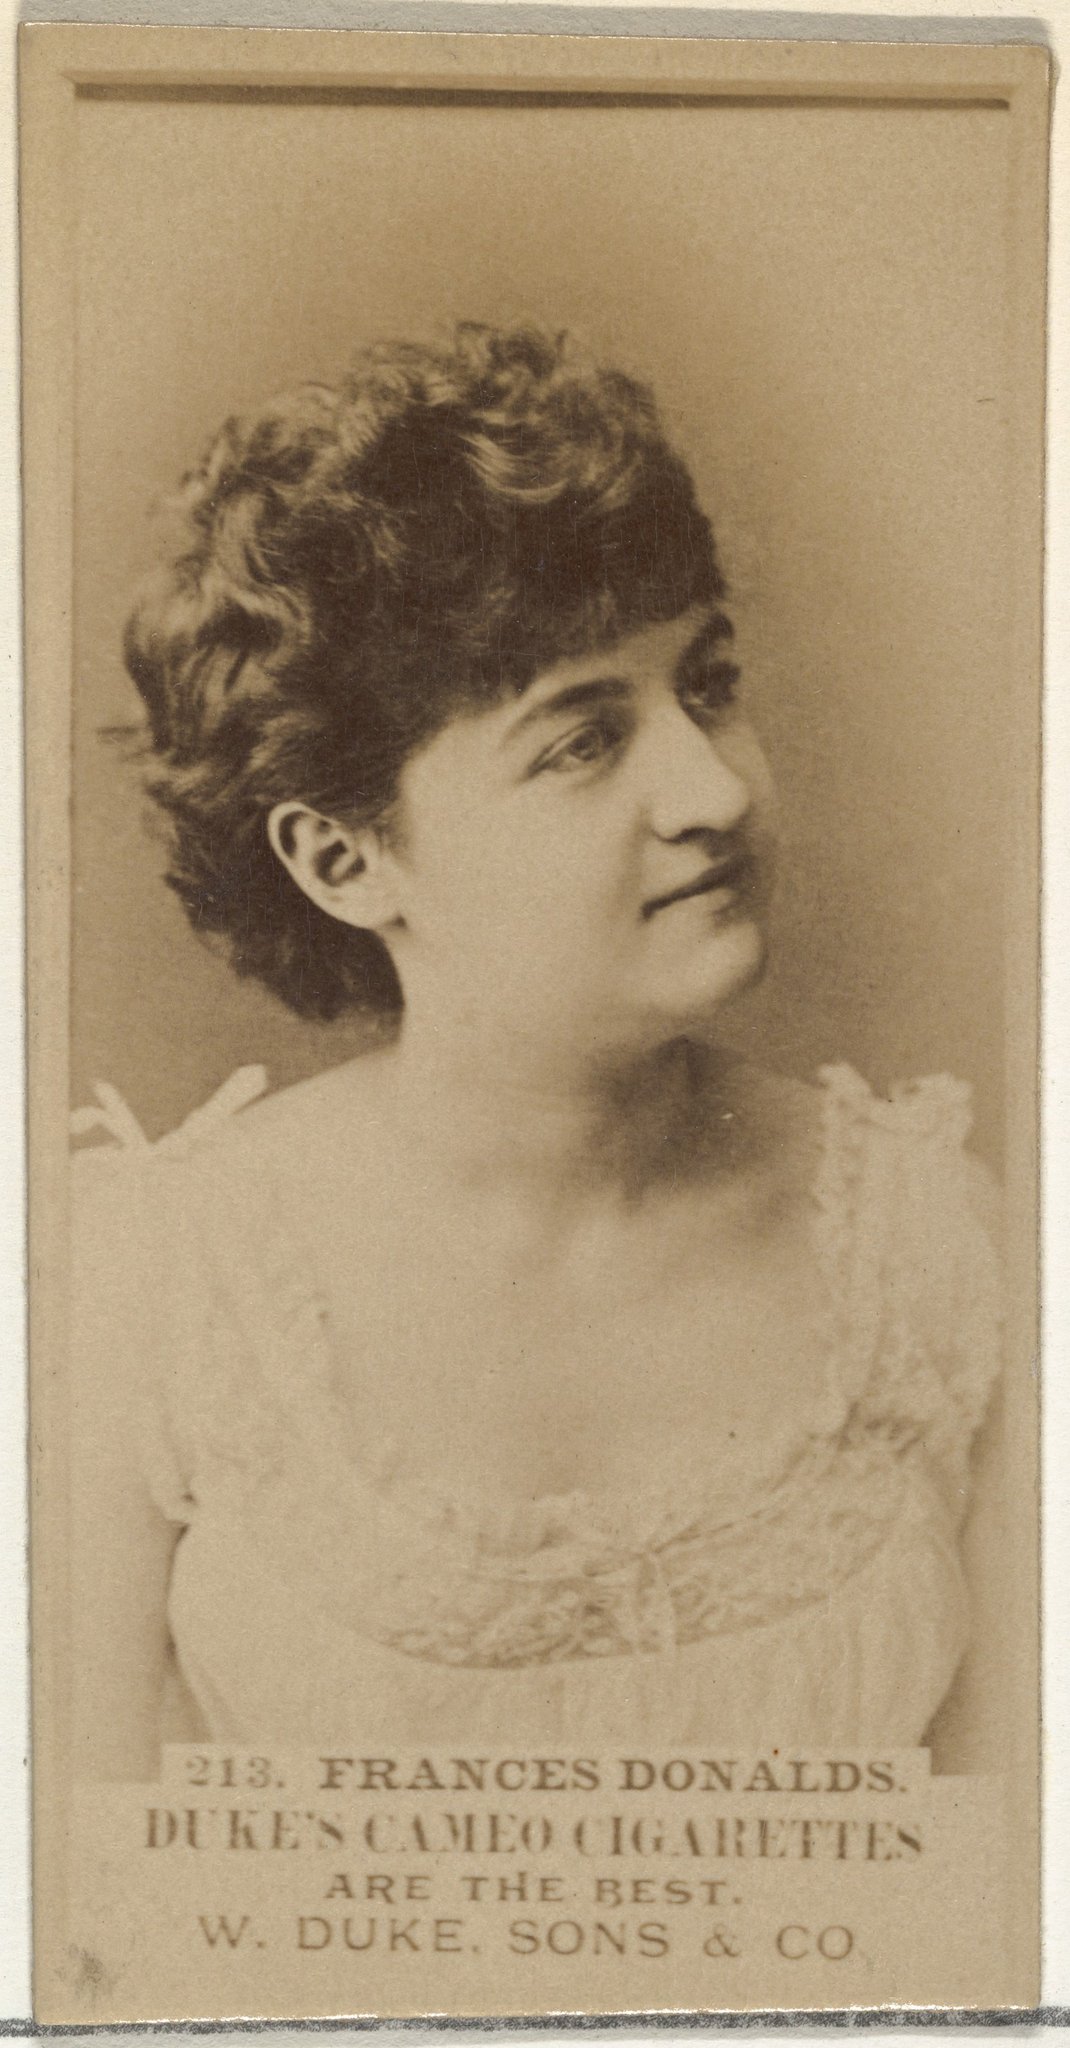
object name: photograph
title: Card Number 213, Frances Donalds, from the Actors and Actresses series (N145-5) issued by Duke Sons & Co. to promote Cameo Cigarettes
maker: w. duke, sons & co.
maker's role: publisher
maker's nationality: american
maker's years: 1870-1920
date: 1880-1889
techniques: albumen silver print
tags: portraits,women,actresses